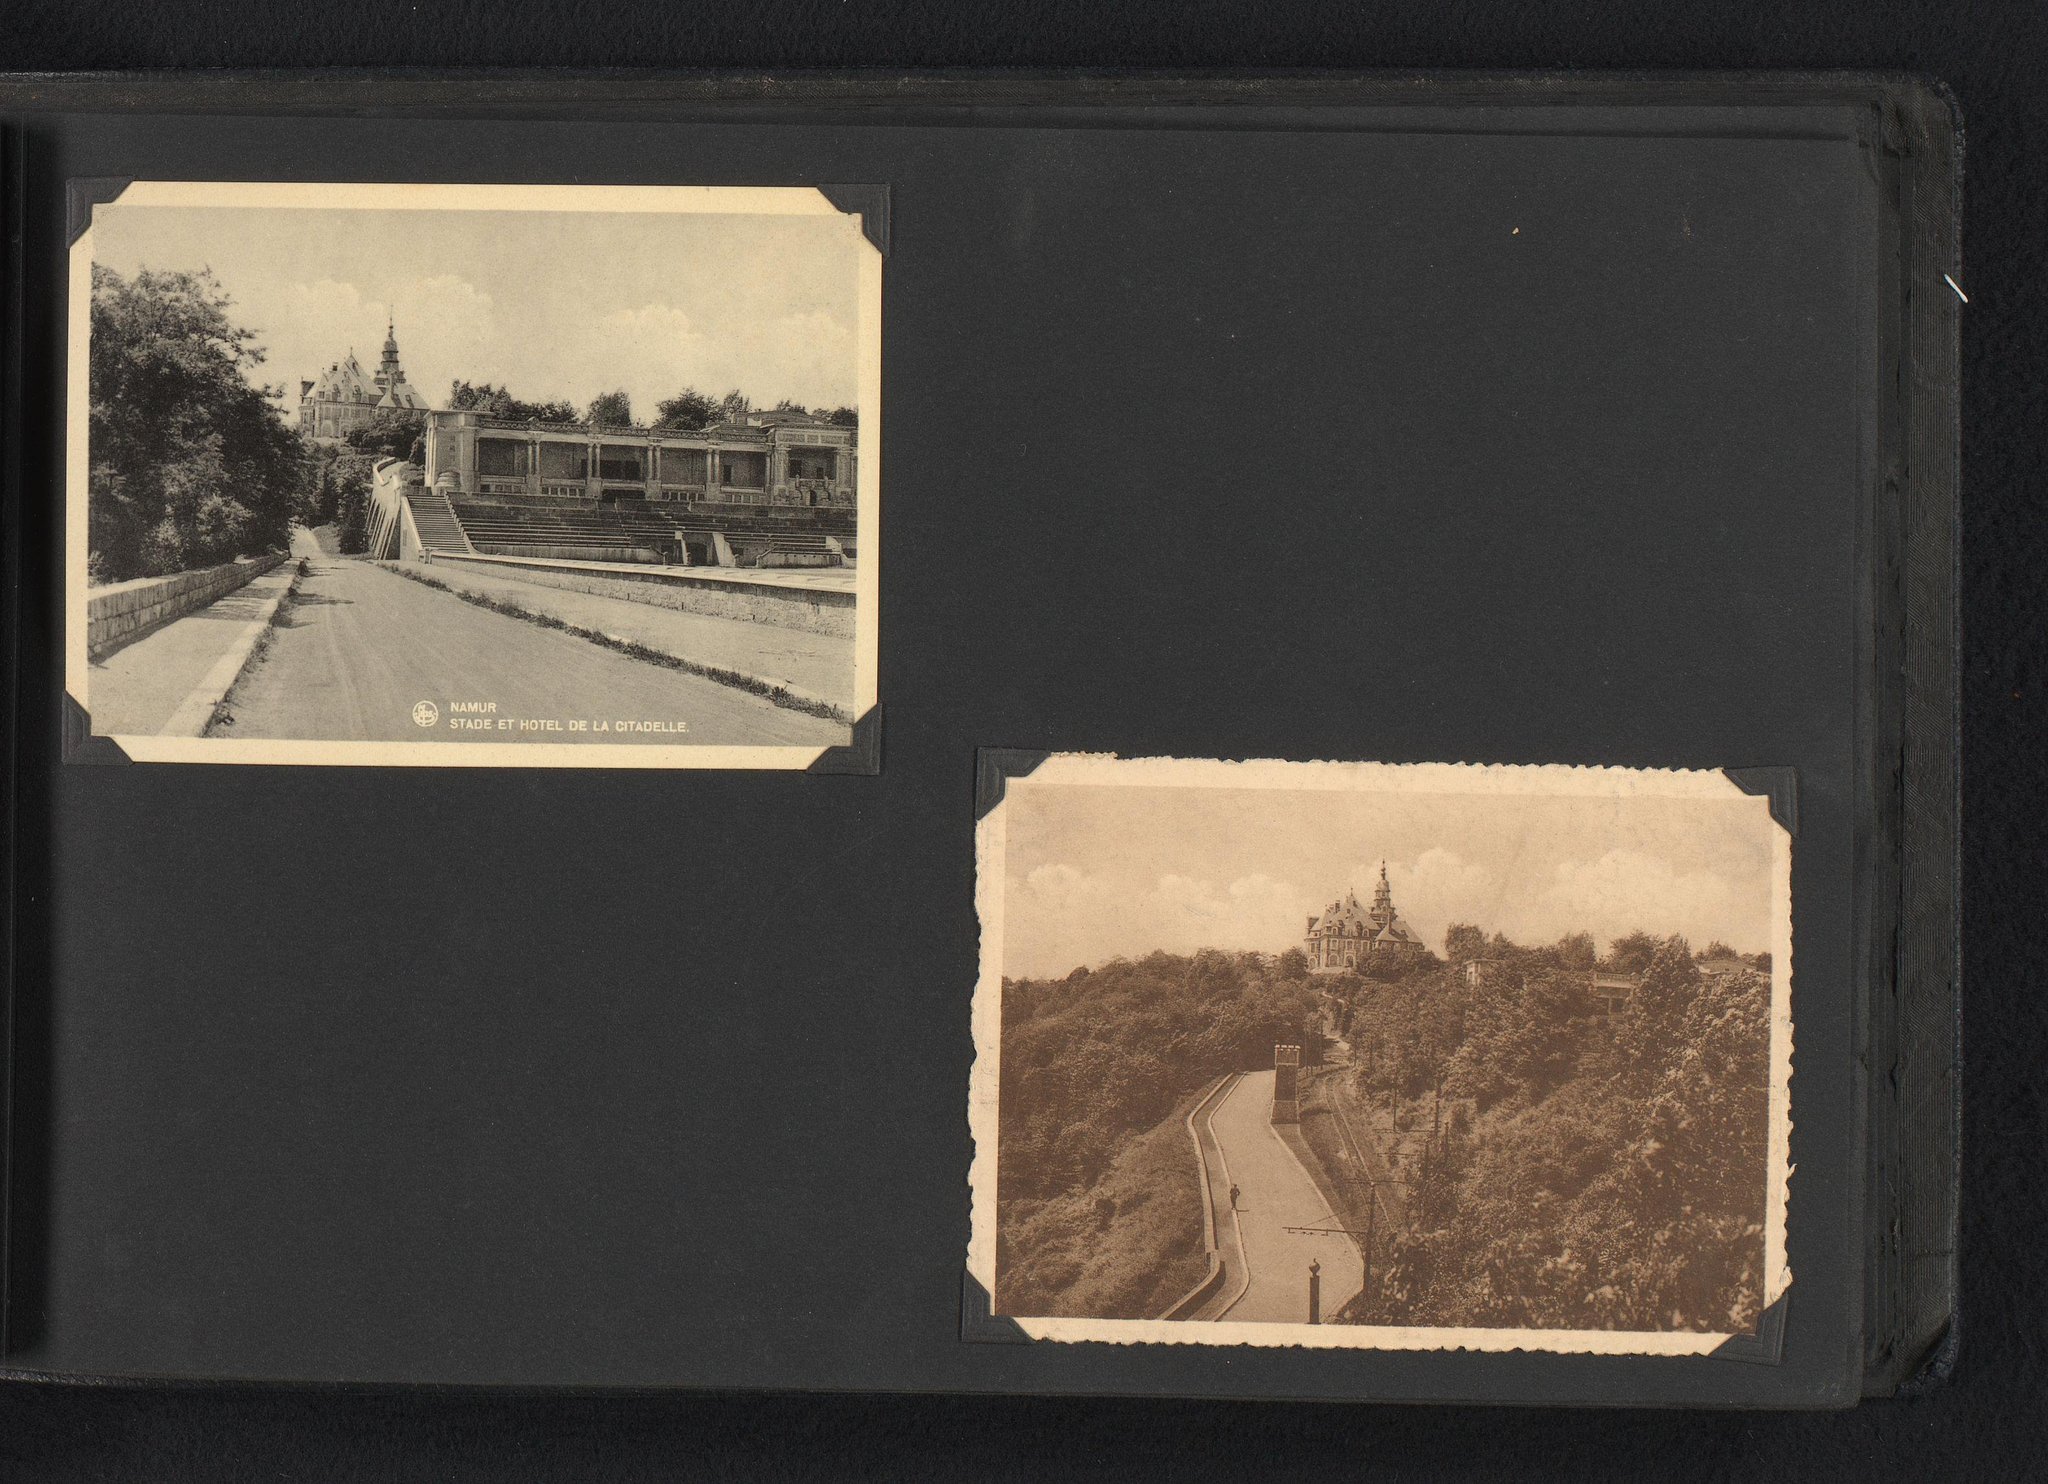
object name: photomechanical print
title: Twee fotomechanische prentbriefkaarten van Namen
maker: Anonymous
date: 1908-1934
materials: cardboard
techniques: photograph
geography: namur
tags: city-view in general; 'veduta'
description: Deze prenten maken deel uit van een album.